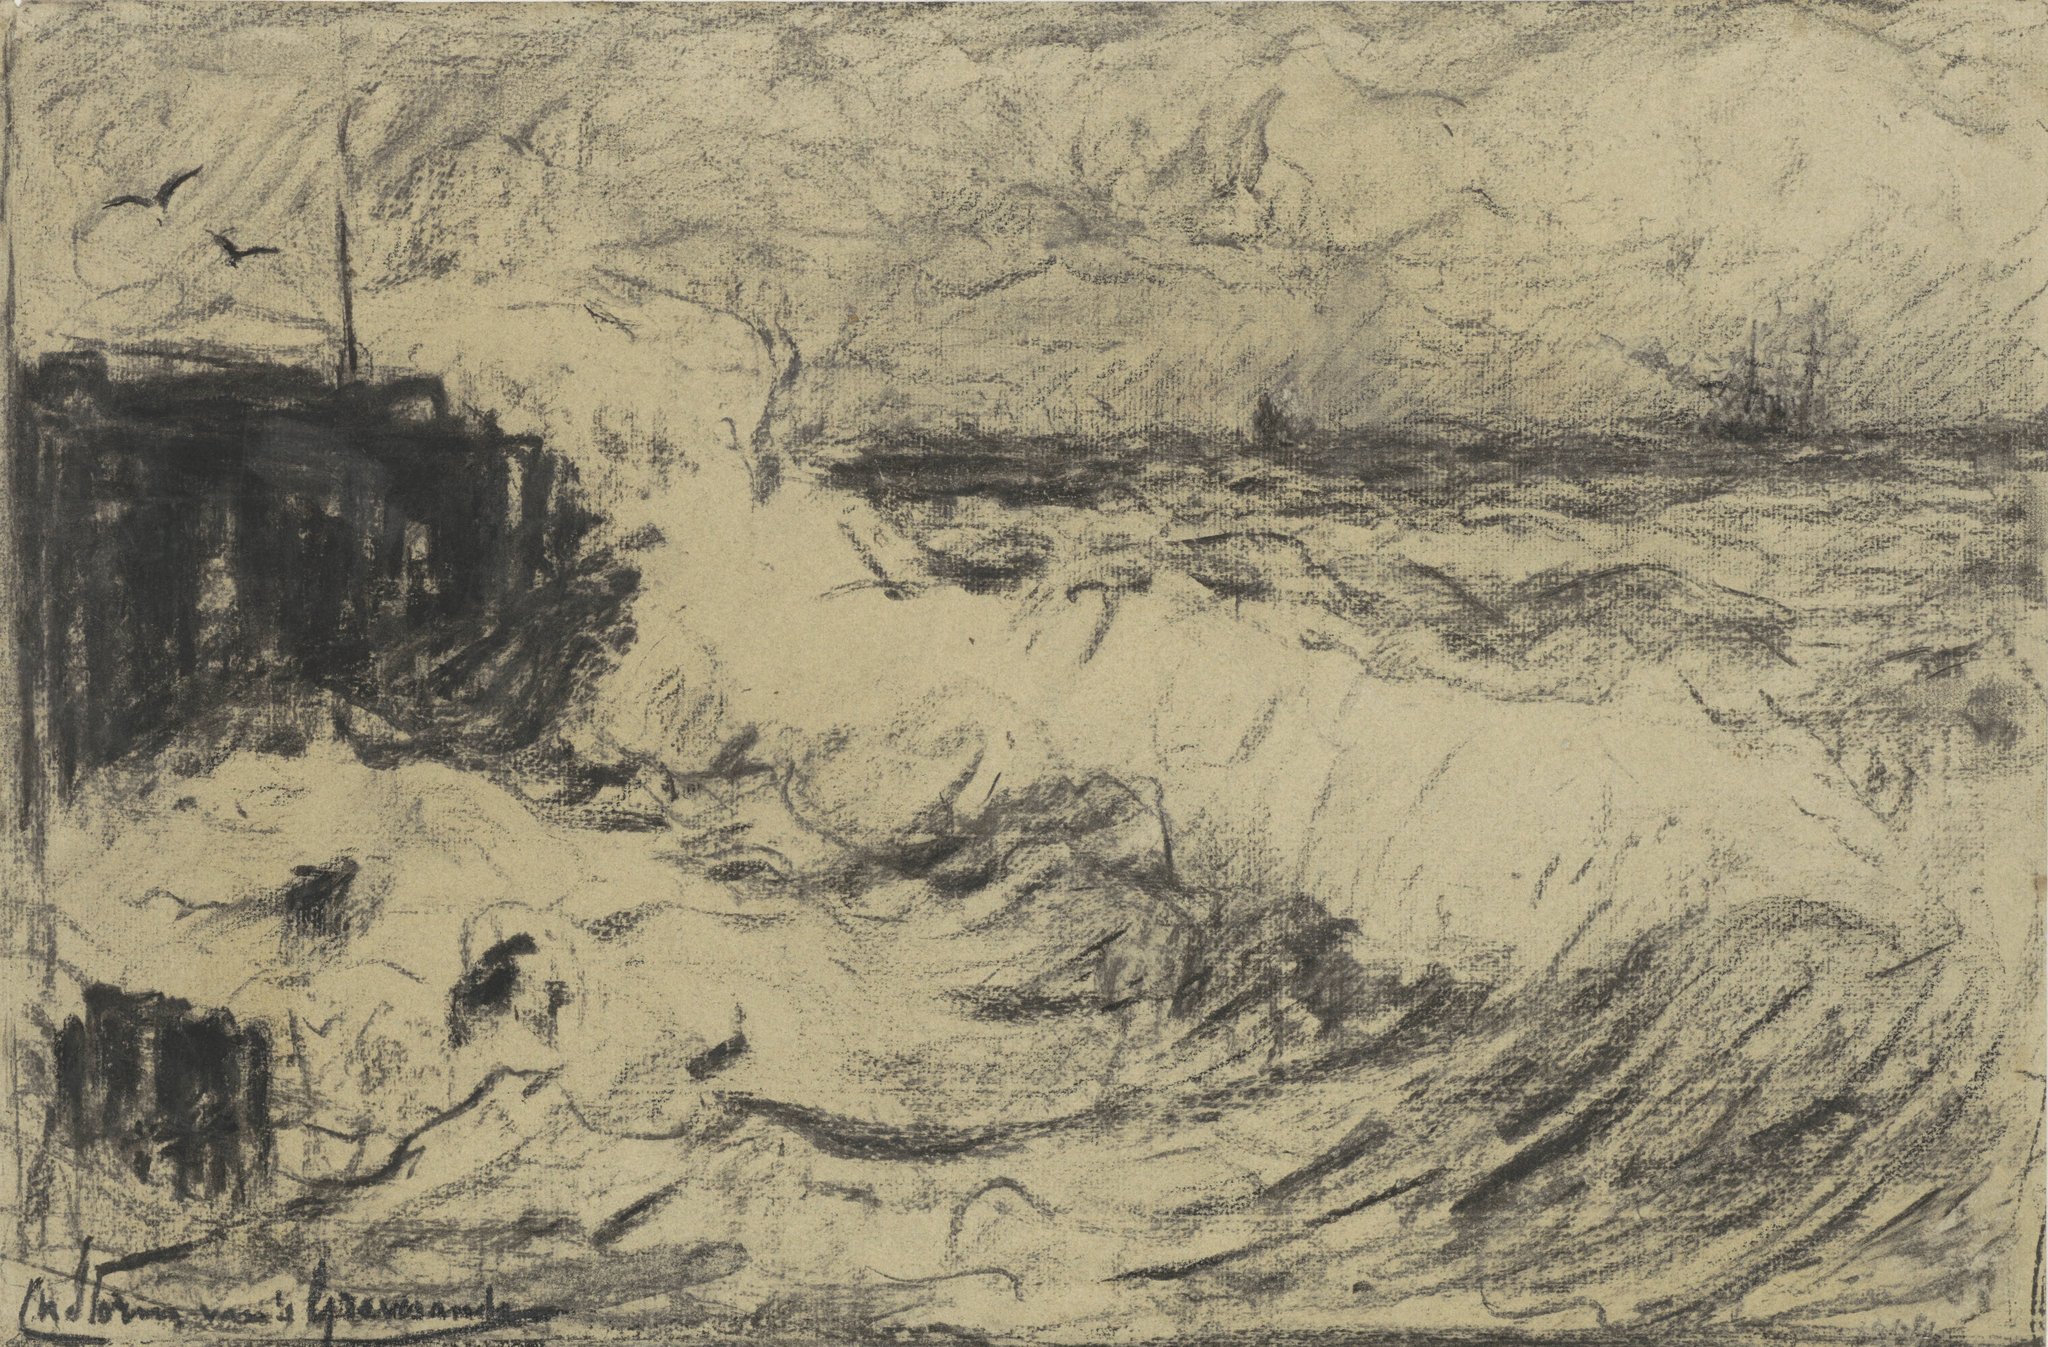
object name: drawing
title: De branding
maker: carel nicolaas storm van s-gravesande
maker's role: draughtsman, print maker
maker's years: 1841-1924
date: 1851-1924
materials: charcoal, paper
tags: coast, france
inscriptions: inscription: ‘Les brisants (Embouchure de l'Escaut)’